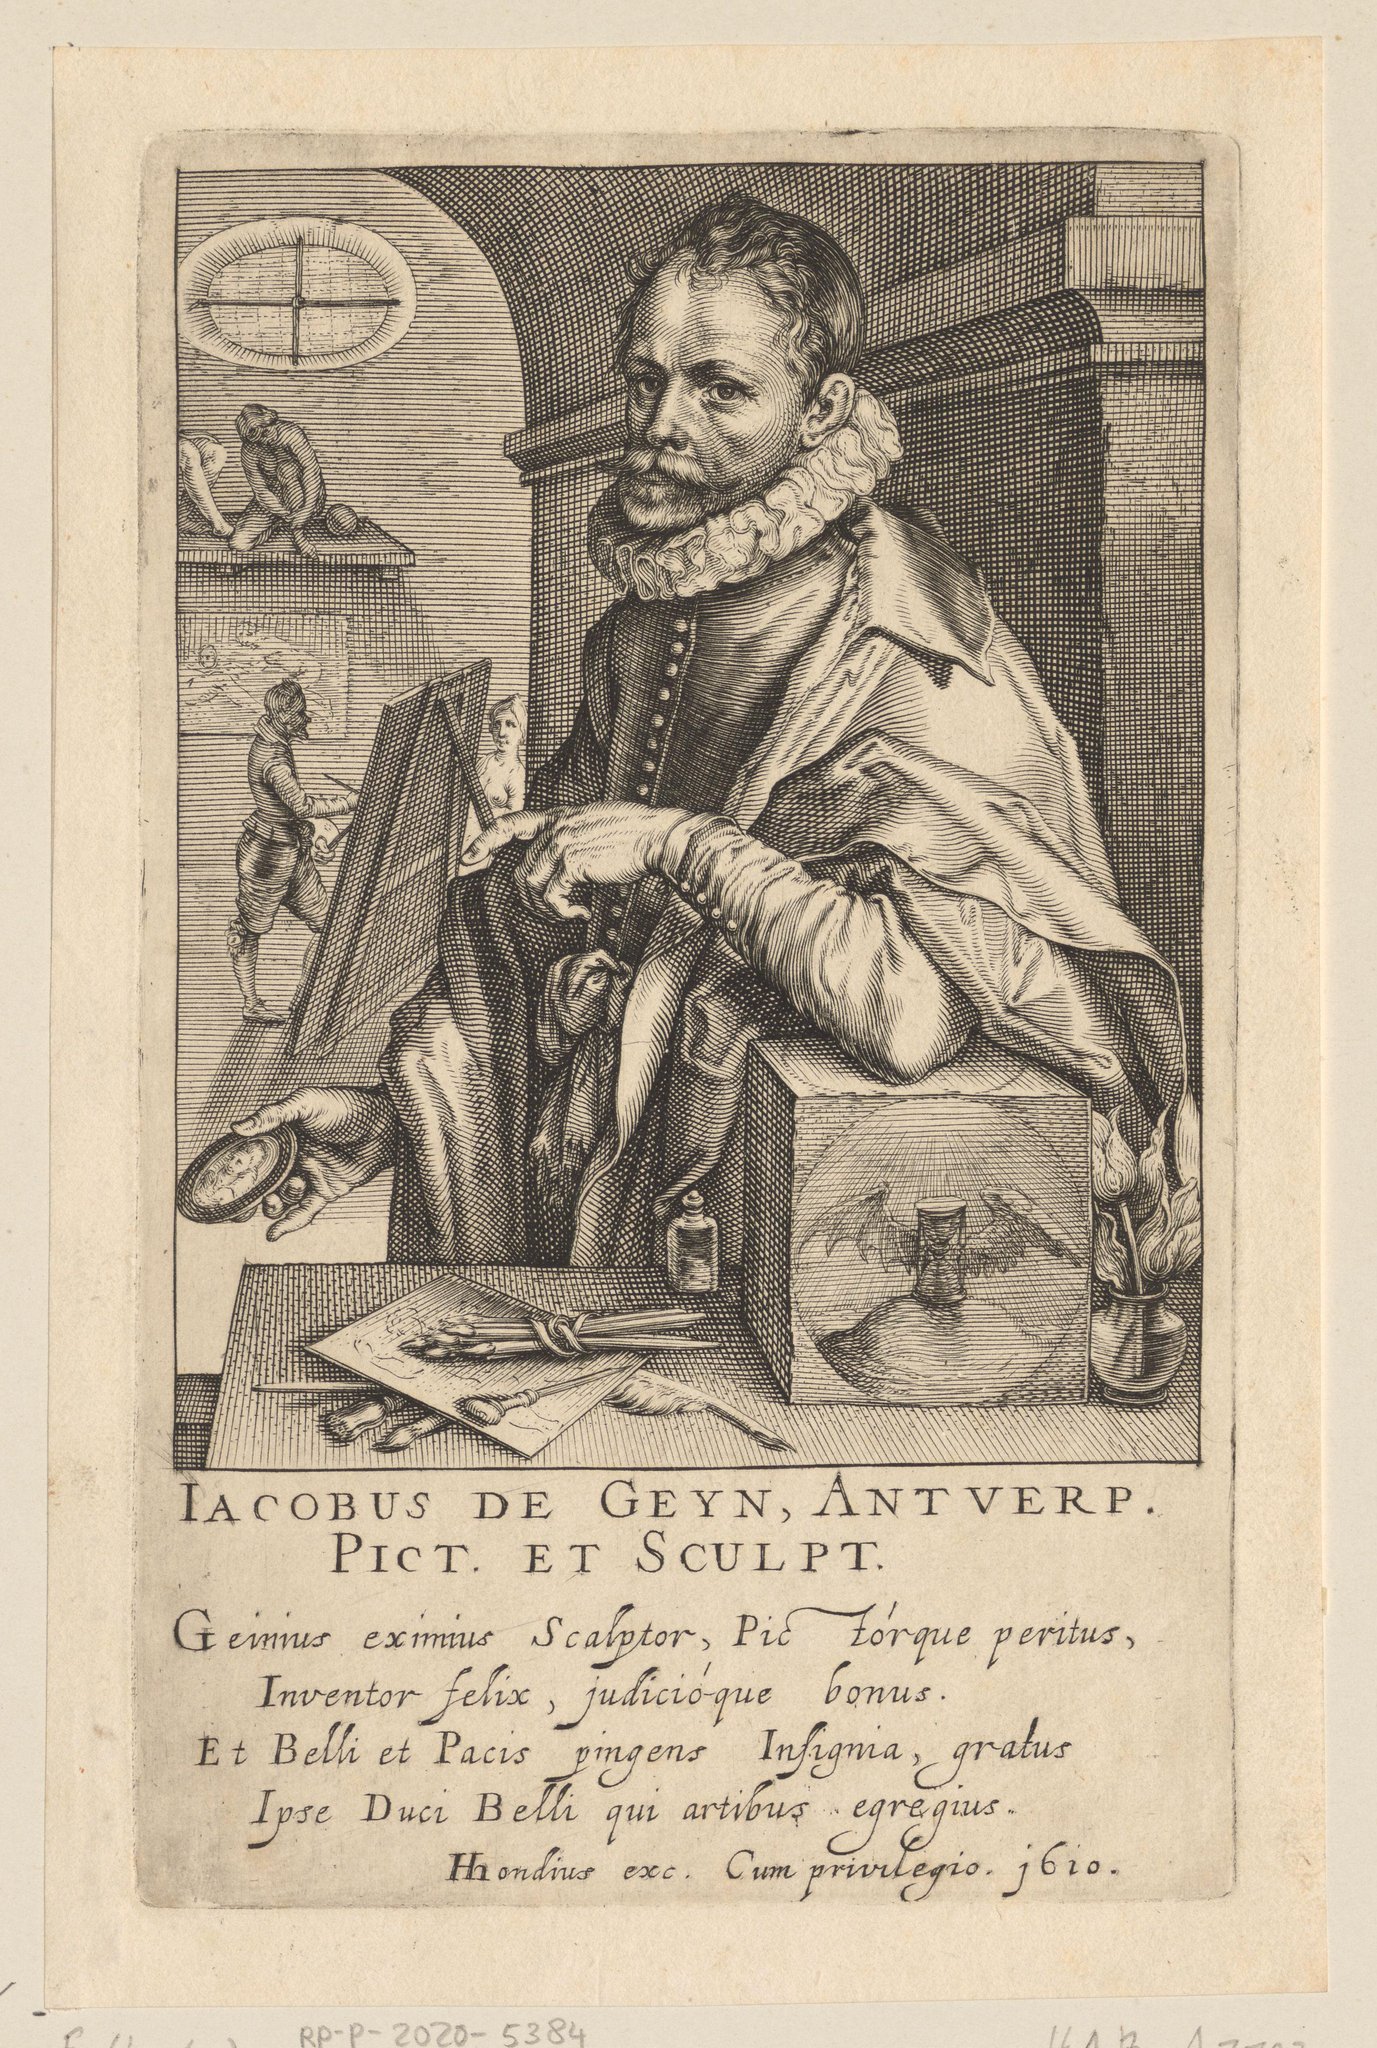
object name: print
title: Portret van Jacques de Gheyn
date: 1610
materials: paper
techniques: engraving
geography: the hague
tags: antwerp, the hague, painter, print maker, jacques de gheyn (ii), historical persons, portrait, self-portrait of painter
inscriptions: collector's mark: Lugt 964